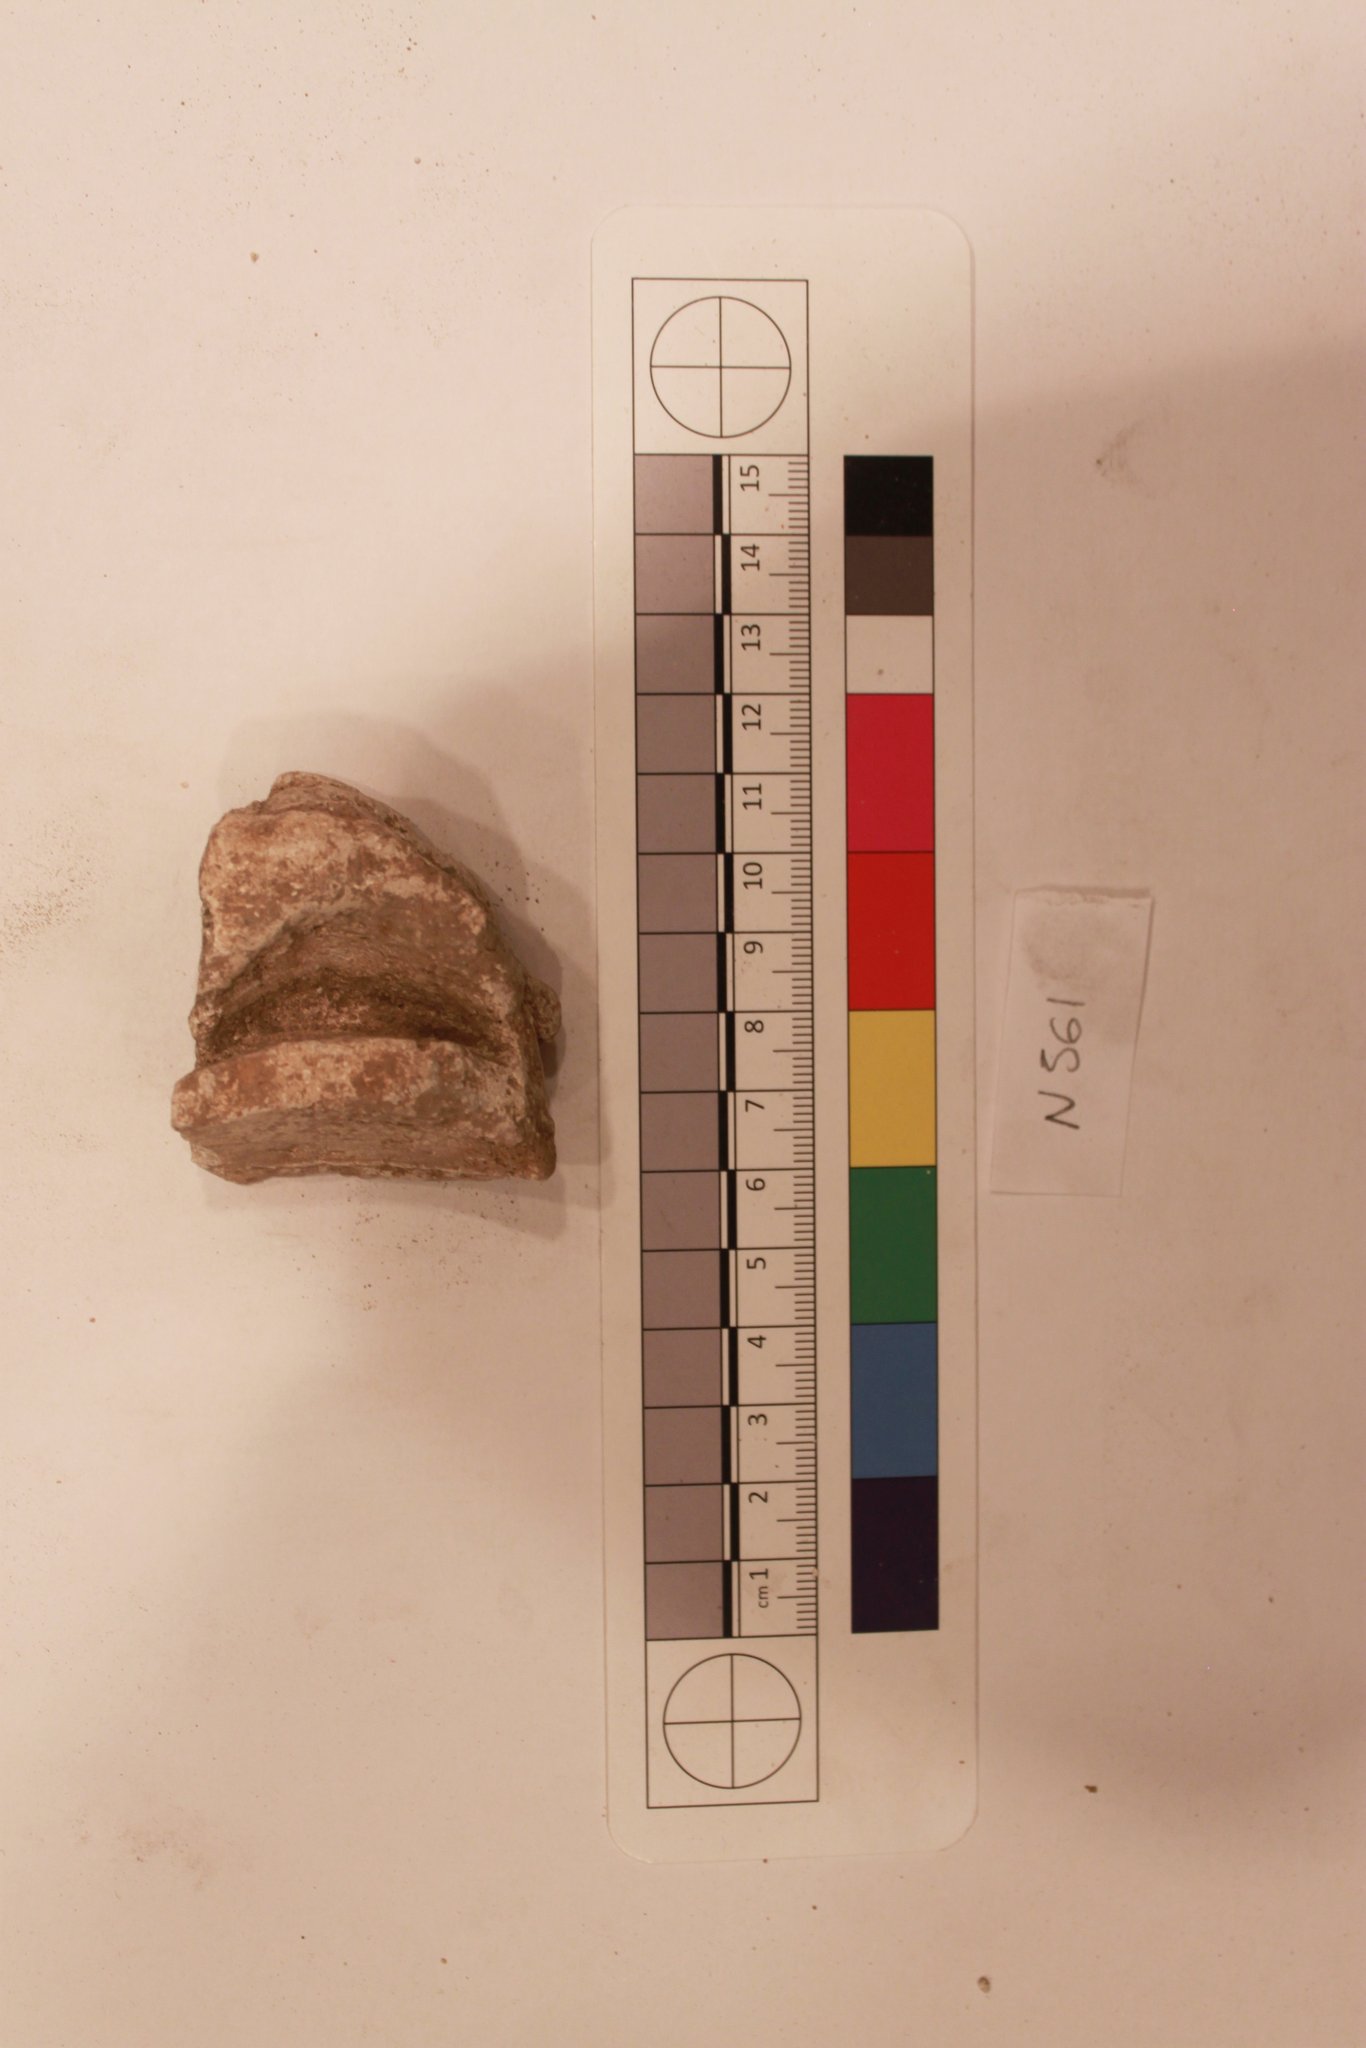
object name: fragment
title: Stucco Fragment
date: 701-1200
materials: plaster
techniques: carving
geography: iran